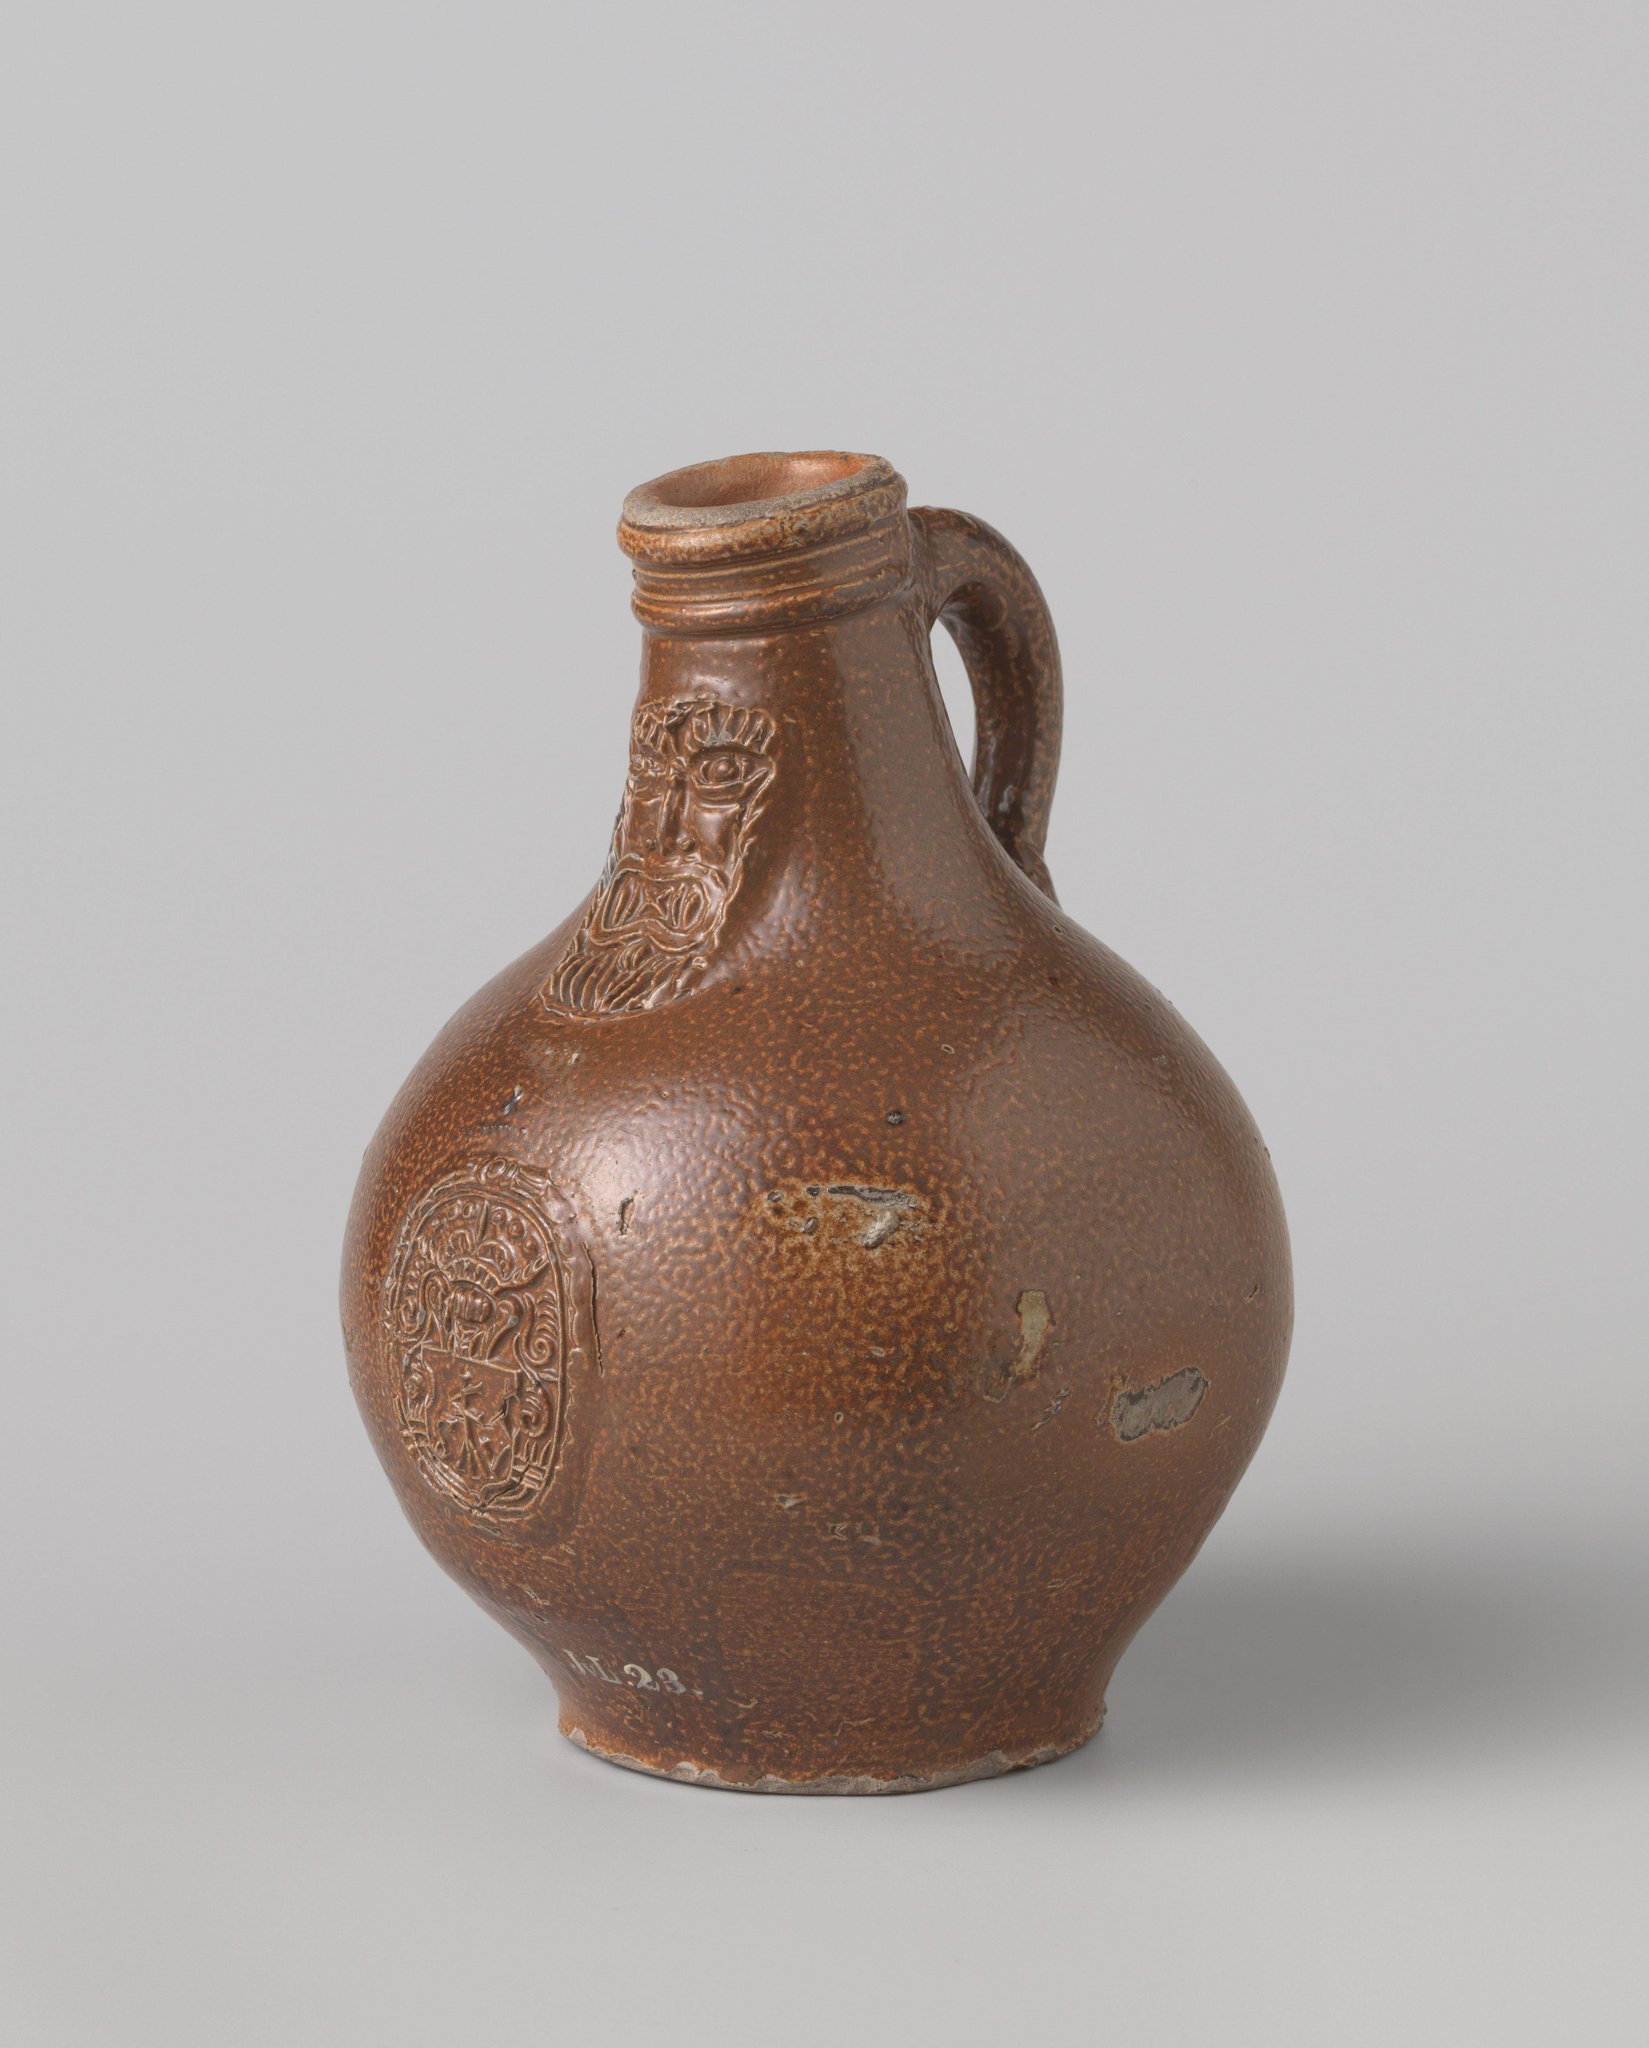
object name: jug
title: Jug (Bartmann jug) with a coat of arms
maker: Anonymous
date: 1625-1749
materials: engobe, glaze, stoneware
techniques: firing, forming, relief, turning, vitrification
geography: frechen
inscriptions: mark: ‘S.V.’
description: Kruik (baardmankruik) van steengoed op hoge voet met een bolvormig lichaam en smalle nek. Het C-vormige oor is bevestigd aan de nek en de schouder. Profielen op de nek. Bedekt met een bruine engobe. Op de buik in reliëf een gedrukt en opgelegd medaillon met een gekroond wapen met het merk 'S.V.'. Op de nek, doorlopend op de schouder, een baardman. Frechen.